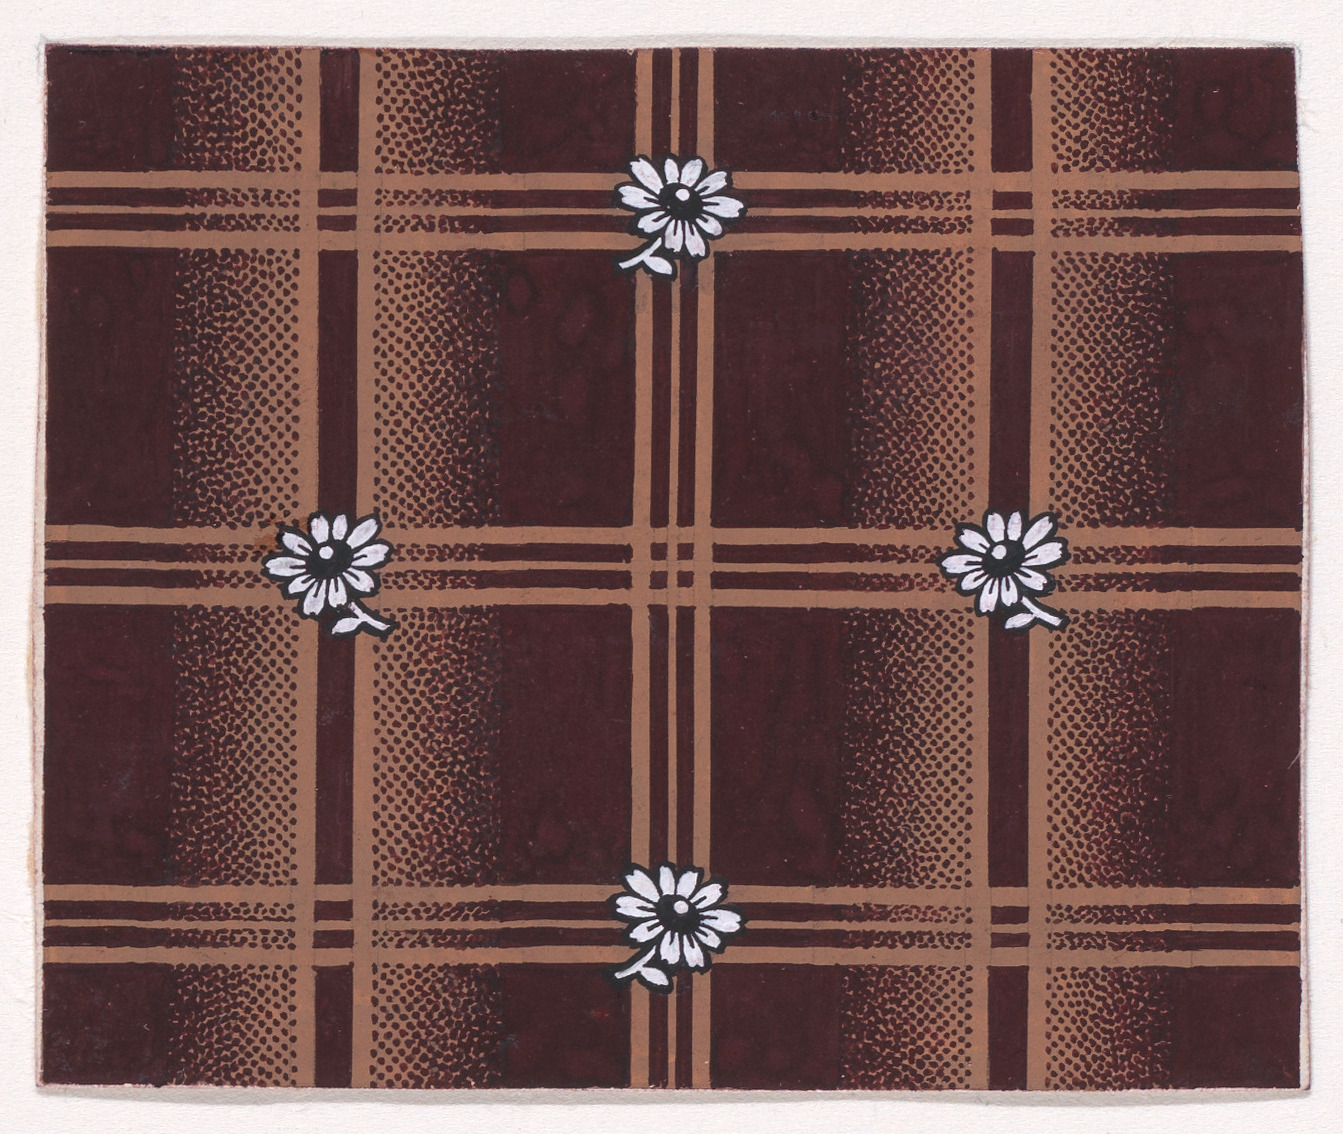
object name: drawing ornament architecture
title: Textile Design with a Tartan Pattern and Stylized Daisies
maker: anonymous, alsatian, 19th century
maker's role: artist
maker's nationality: alsatian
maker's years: 1800-1900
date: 1840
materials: gouache